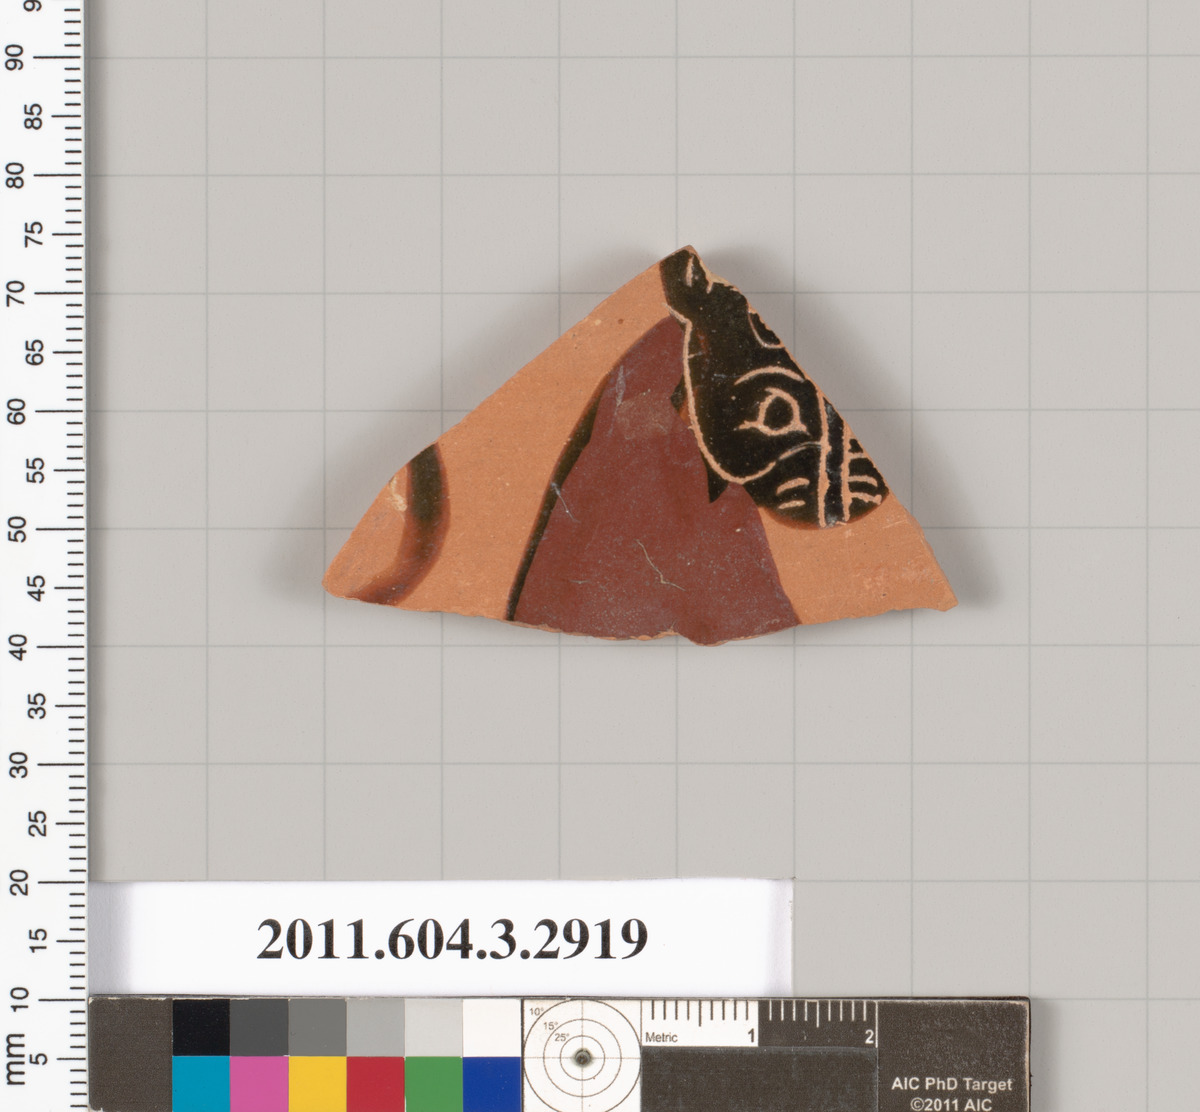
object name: neck amphora fragment, tyrrhenian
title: Terracotta fragment of a neck-amphora (jar), Tyrrhenian?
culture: greek, attic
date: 575-551 BCE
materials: terracotta